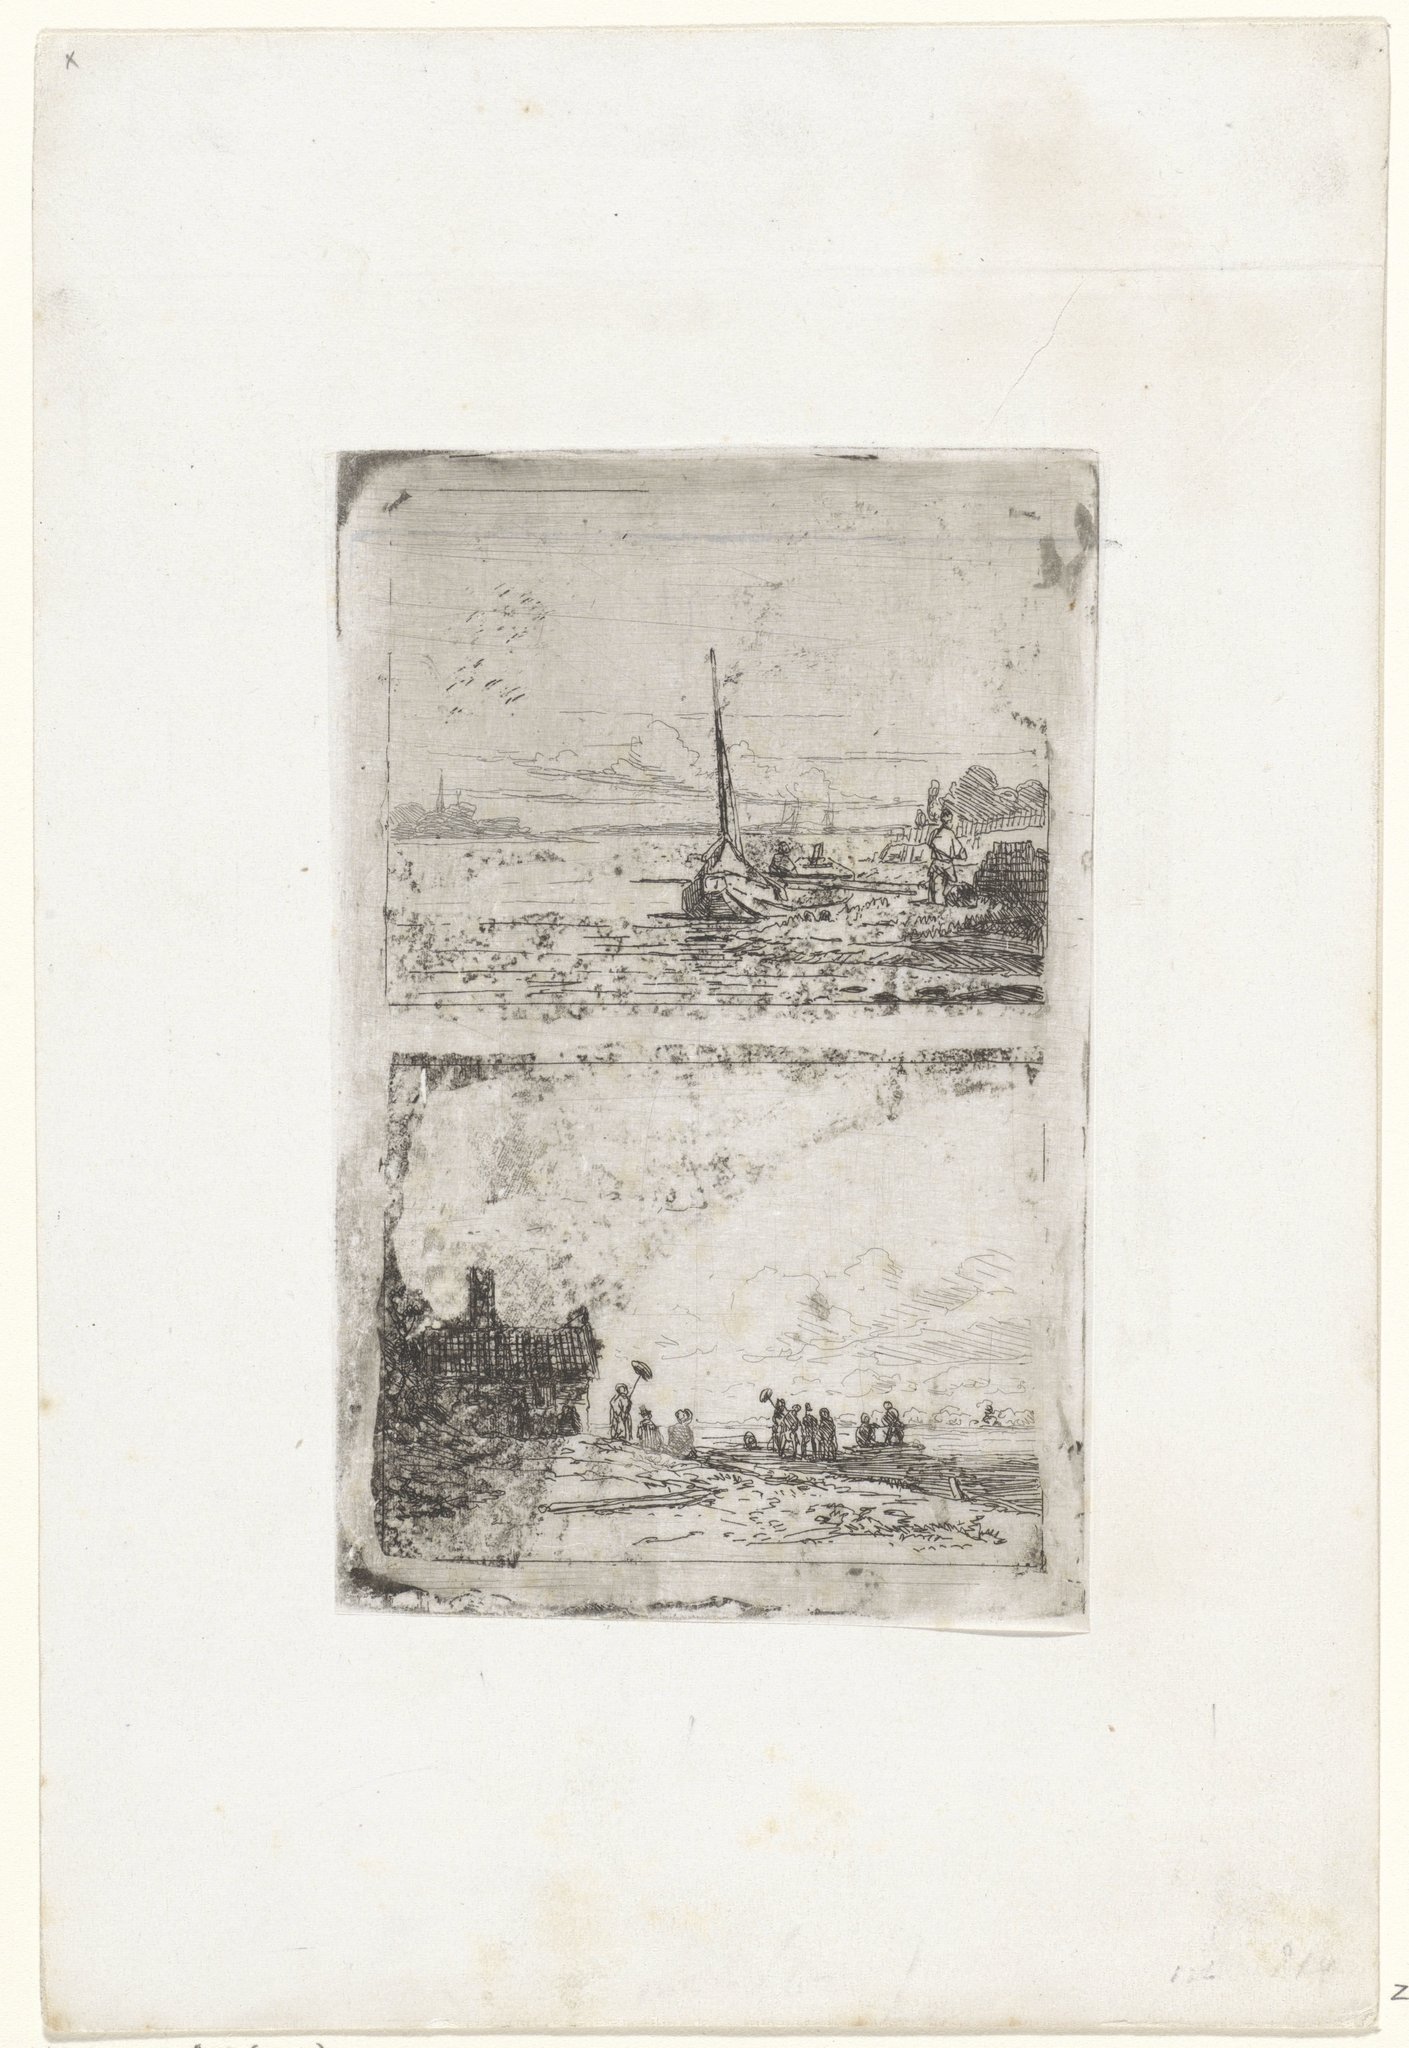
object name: print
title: Twee rivierlandschappen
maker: jan weissenbruch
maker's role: painter, print maker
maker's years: 1822-1880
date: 1837-1880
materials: paper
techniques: etching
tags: landscapes, river, river bank, housing, ferry, rhenen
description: Twee landschappen op één plaat. Boven een landschap met een zeilschip en een figuur aan een rivieroever. Onder ligt een huis aan een weg bij het water. Verder zijn enkele figuren te zien, van wie twee op een bootje.